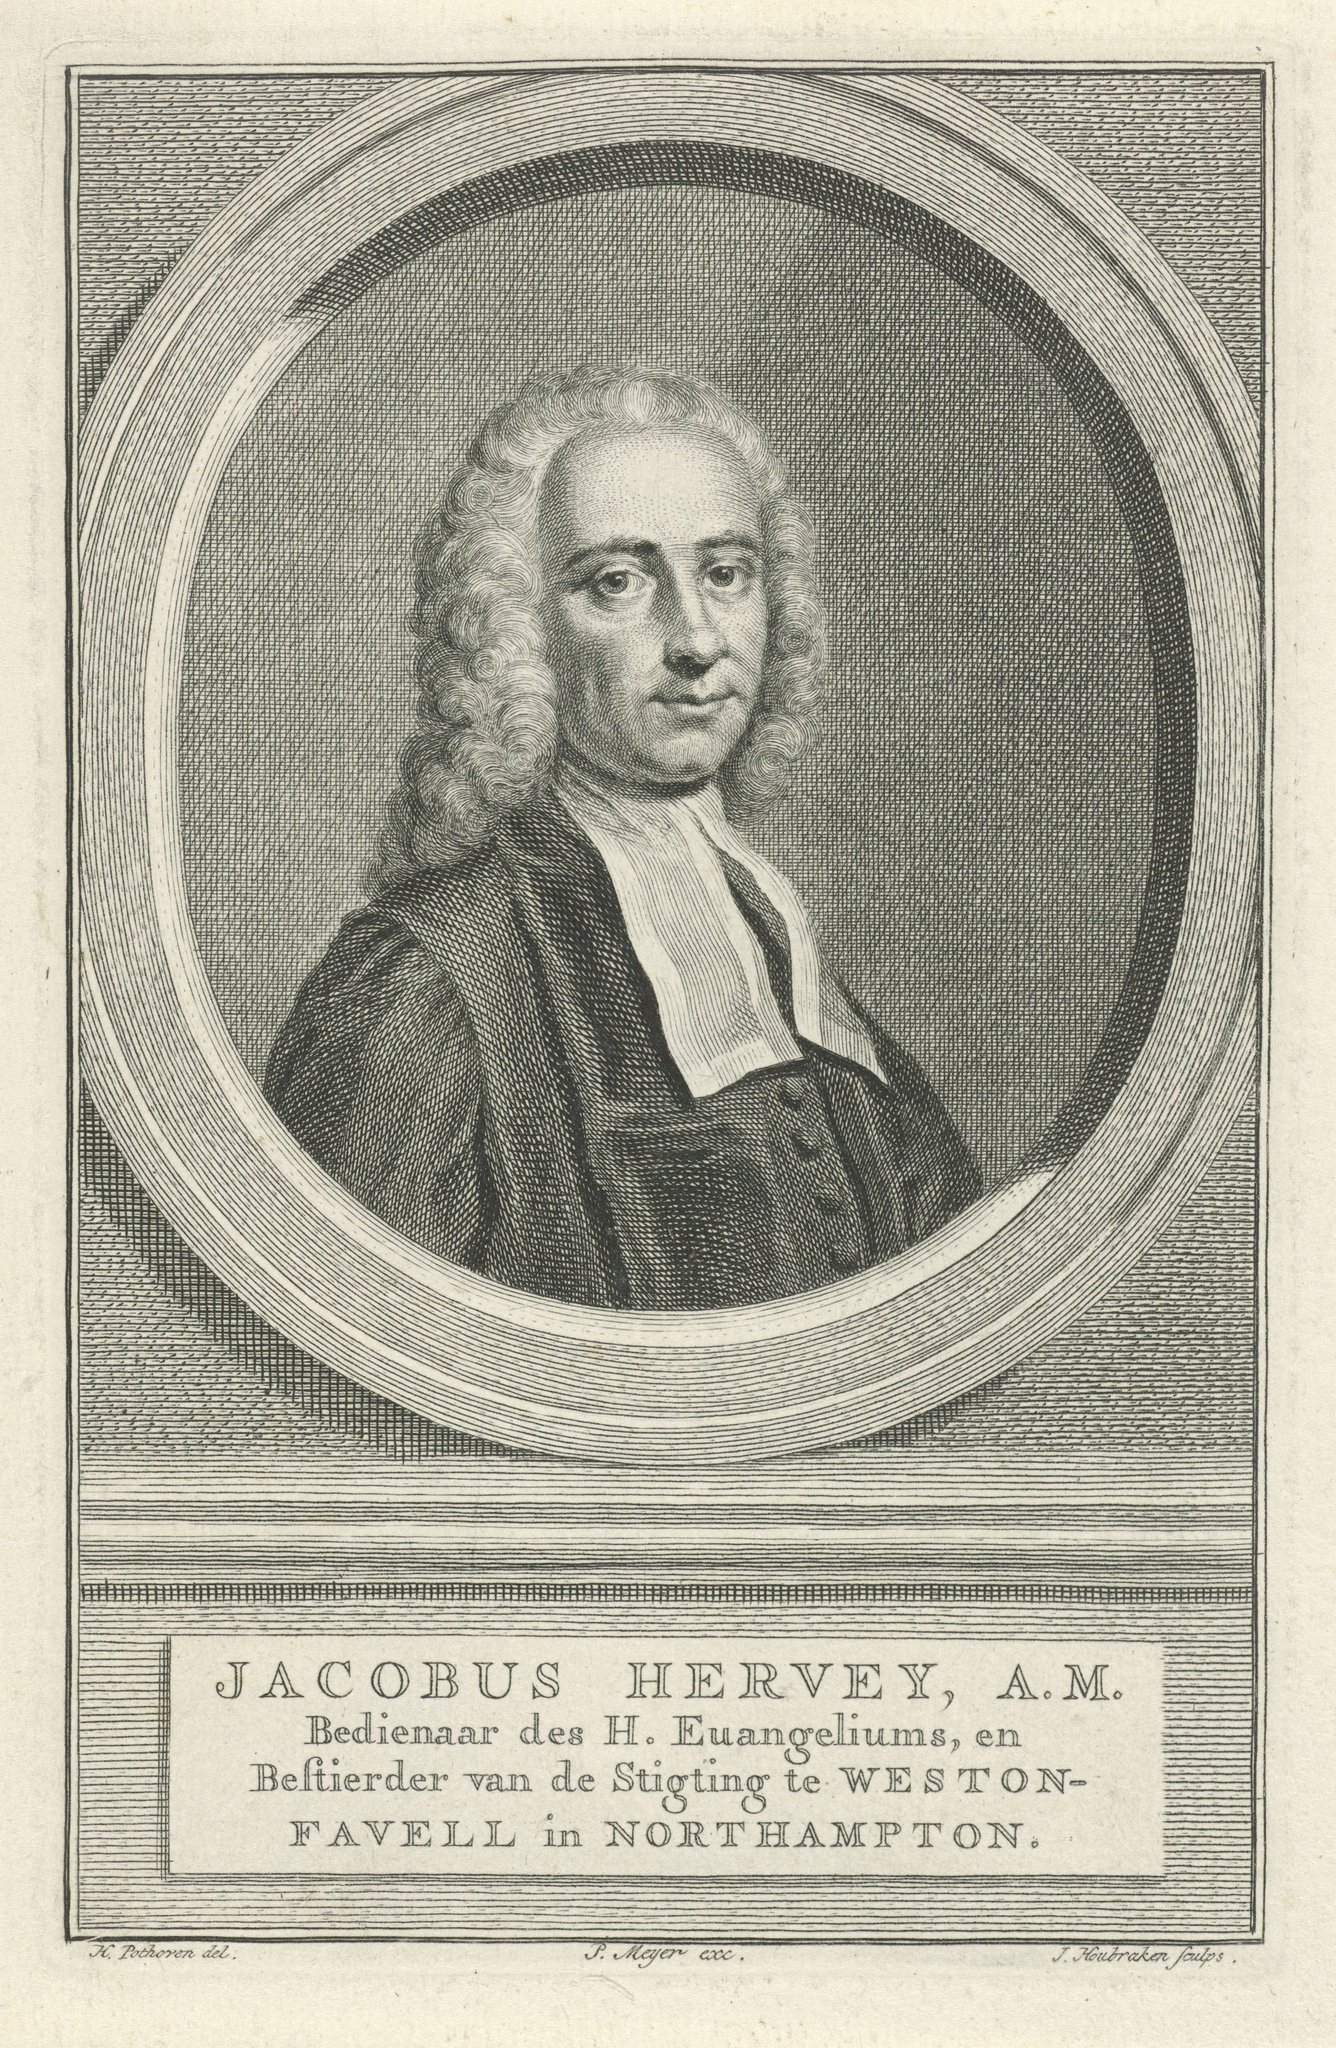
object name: print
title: Jacobus Hervey, A.M.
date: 1747-1780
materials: paper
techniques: engraving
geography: amsterdam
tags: jakobus hervey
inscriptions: collector's mark: Lugt 2228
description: Buste naar rechts van Jakobus Hervey in een ovaal. Het portret rust op een plint waarop zijn naam en gegevens in vier regels in het Nederlands.